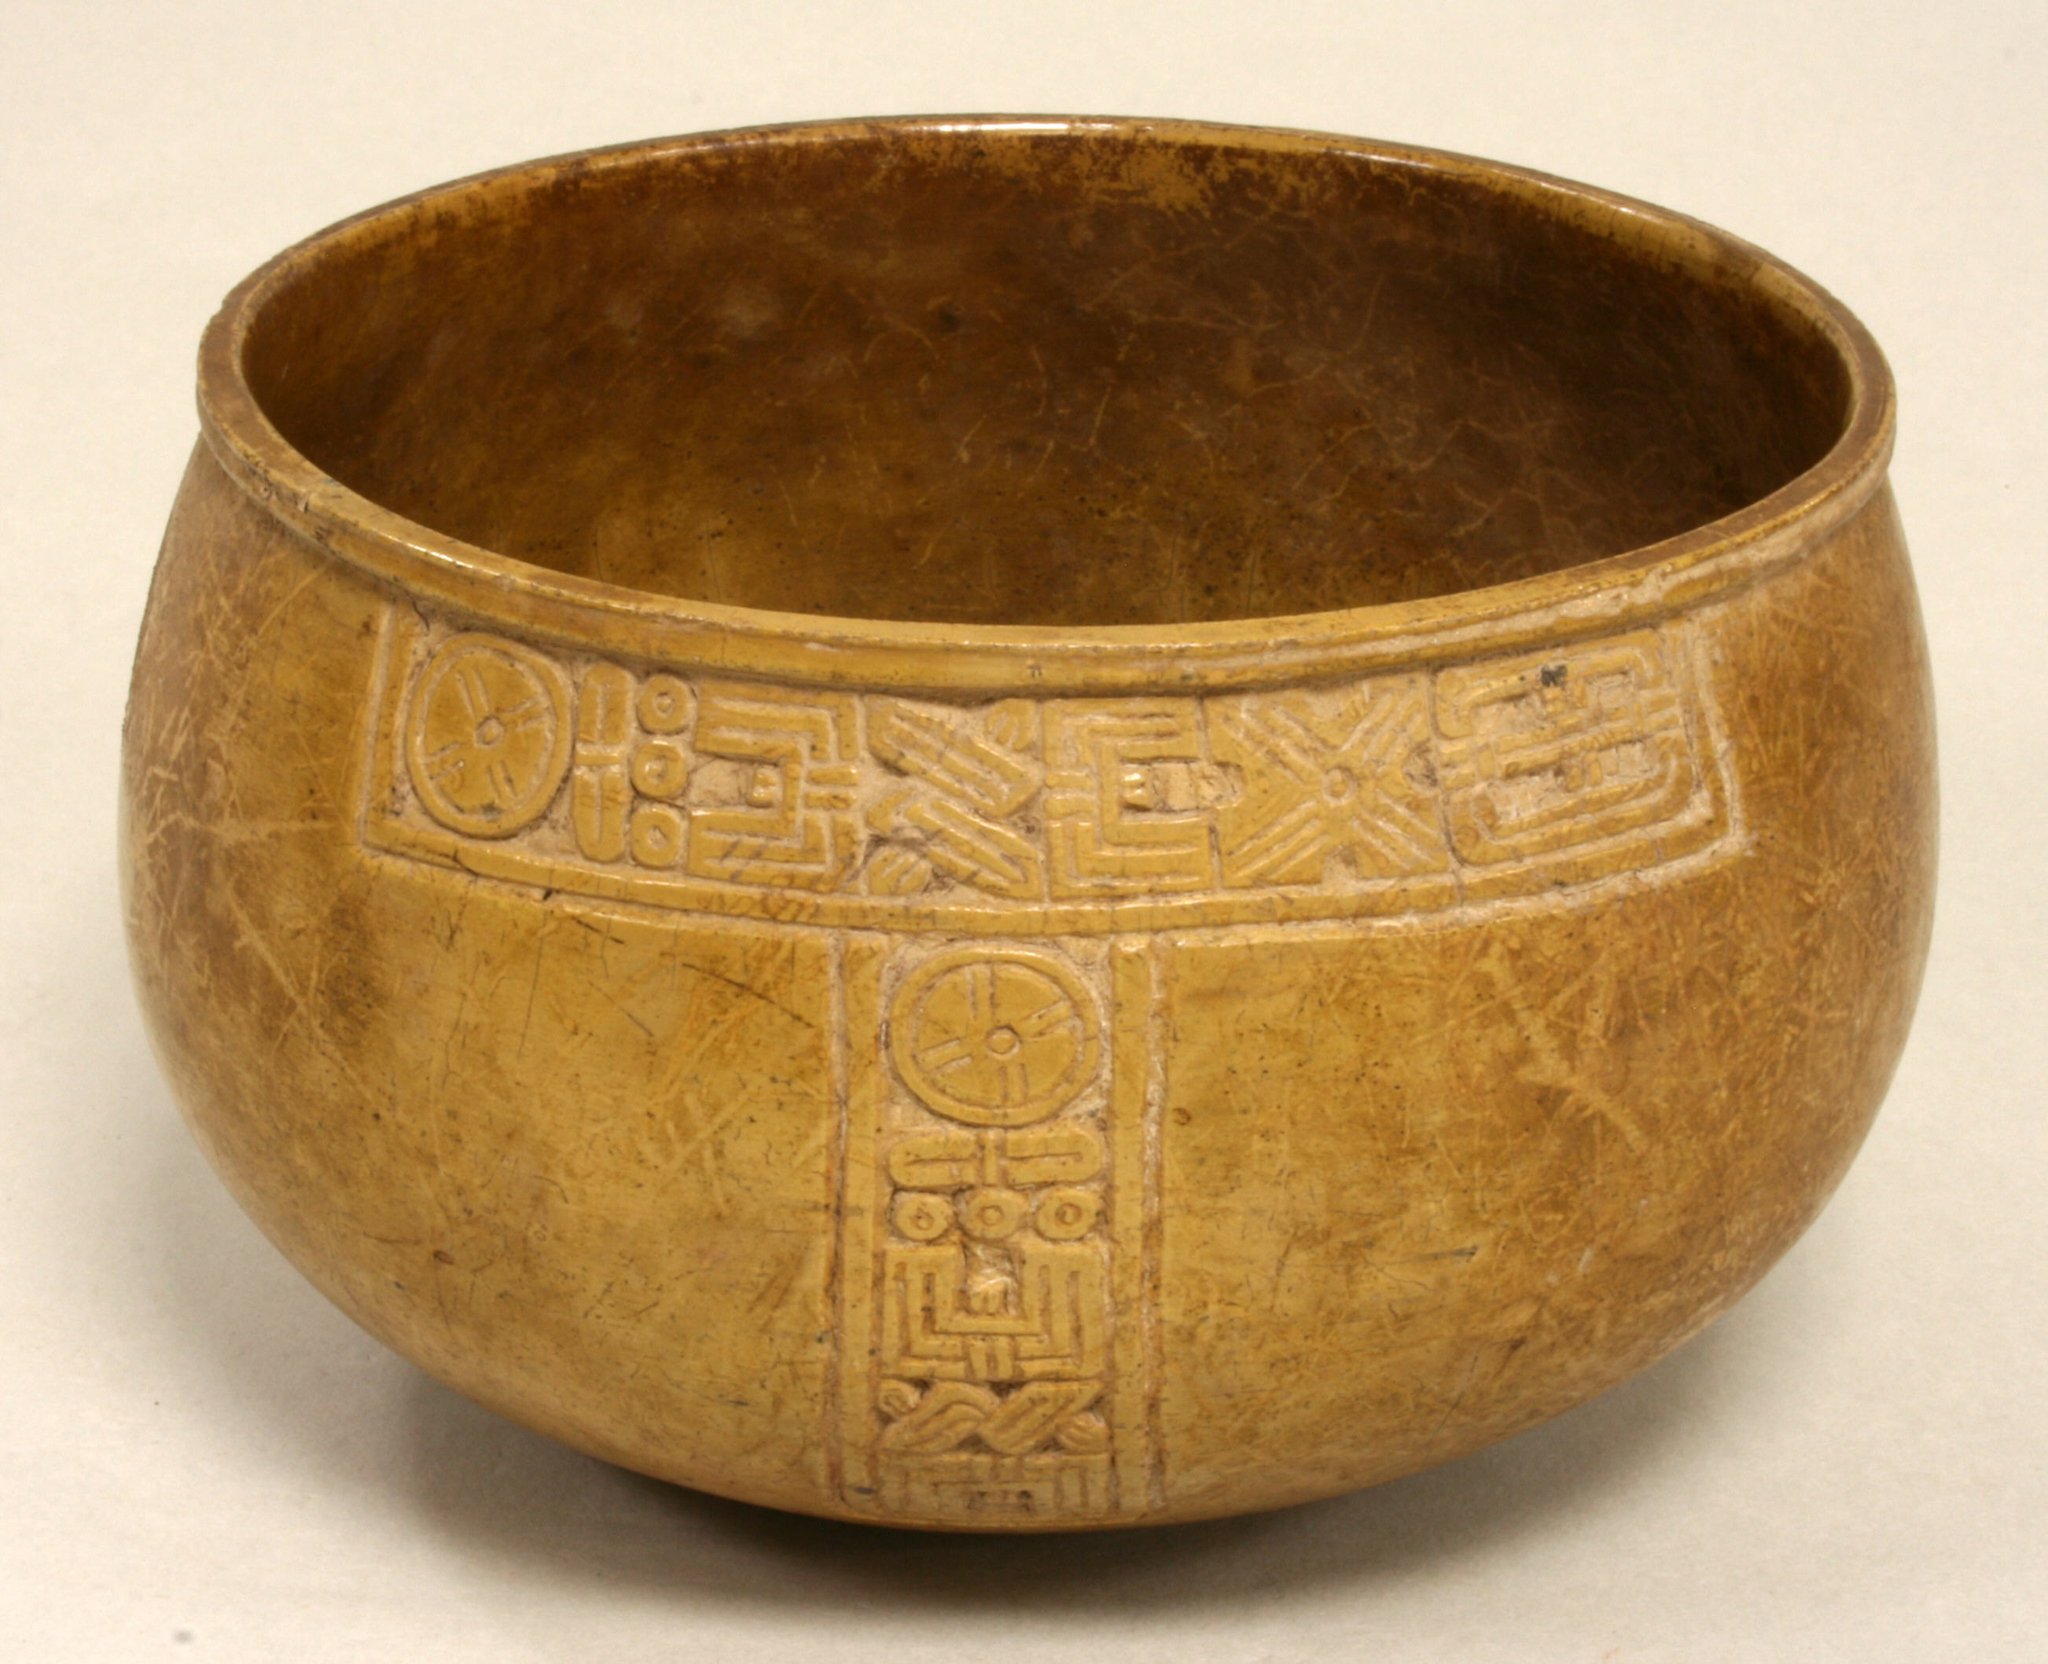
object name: bowl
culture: maya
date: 801-1000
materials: ceramic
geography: mexico